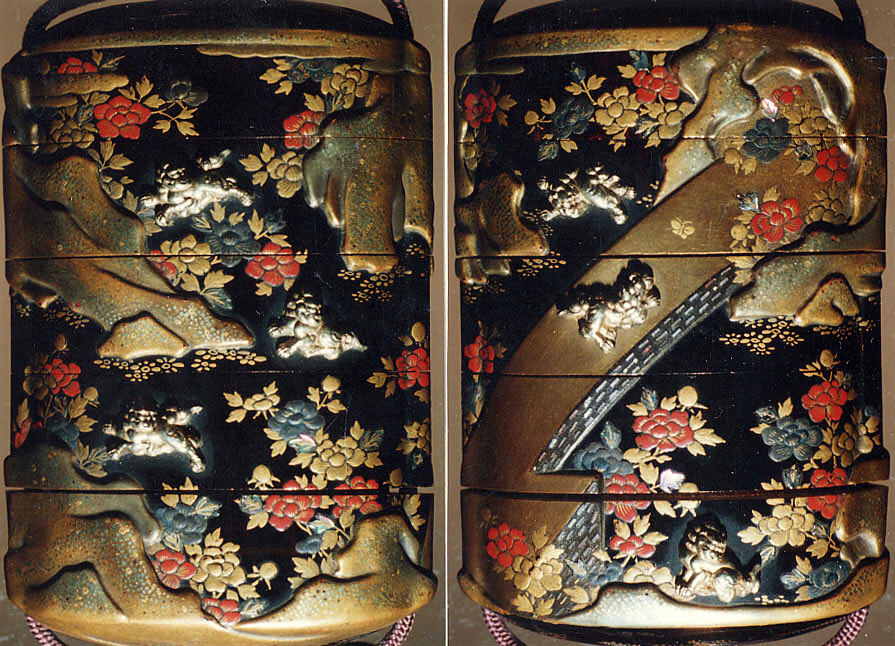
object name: inrō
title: Case (Inrō) with Design of Chinese Lions (Karashishi) with Peonies and on Bridge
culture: japanese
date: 1701-1900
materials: gold, lacquer, metal, silver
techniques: fundame, hiramakie, roiro, maki-e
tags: bridges,lions,peonies